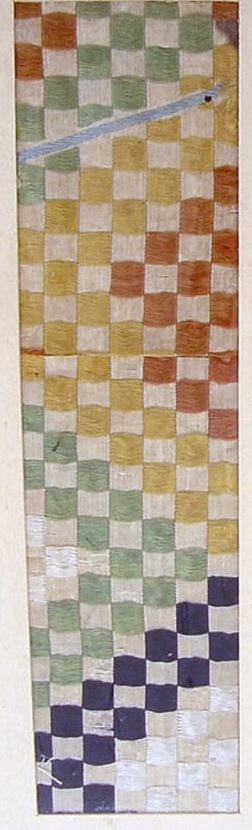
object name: piece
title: Textile with Polychrome Checks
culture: japanese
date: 1615-1868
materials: silk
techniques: brocade, weave